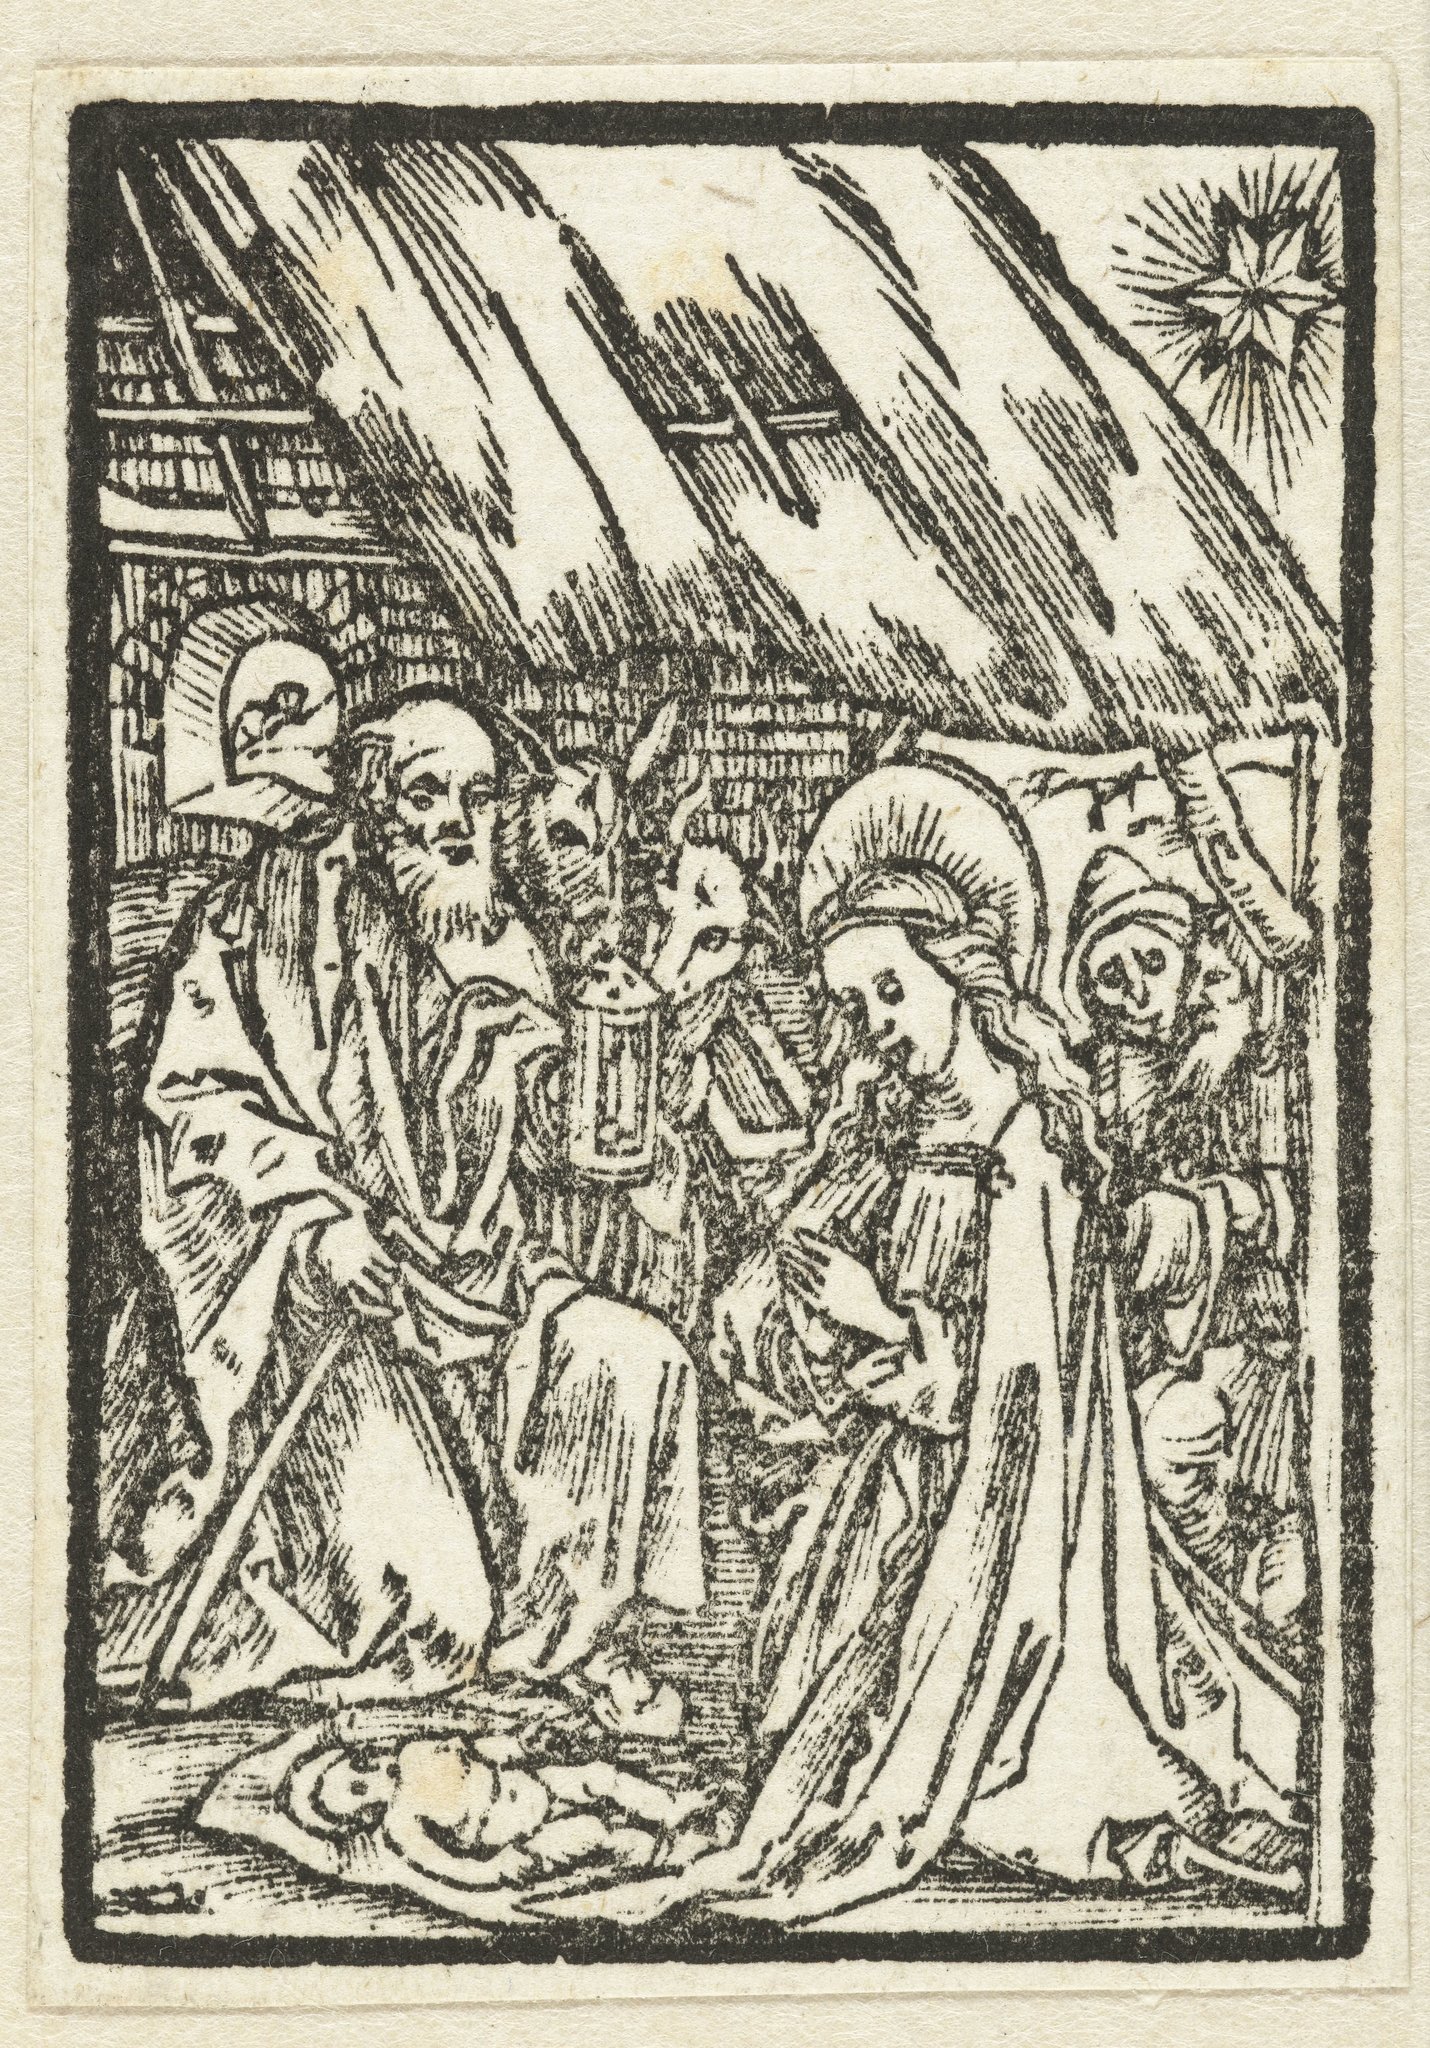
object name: print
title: Aanbidding door de herders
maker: albrecht dürer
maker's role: draughtsman, painter, print maker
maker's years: 1471-1528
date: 1503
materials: paper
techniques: woodcut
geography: nuremberg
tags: adoration of the christ-child by the shepherds; mary and joseph present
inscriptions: collector's mark: Lugt 240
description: Maria en Jozef knielen in een stal bij het Christuskind. Achter hen komen de herders binnen.